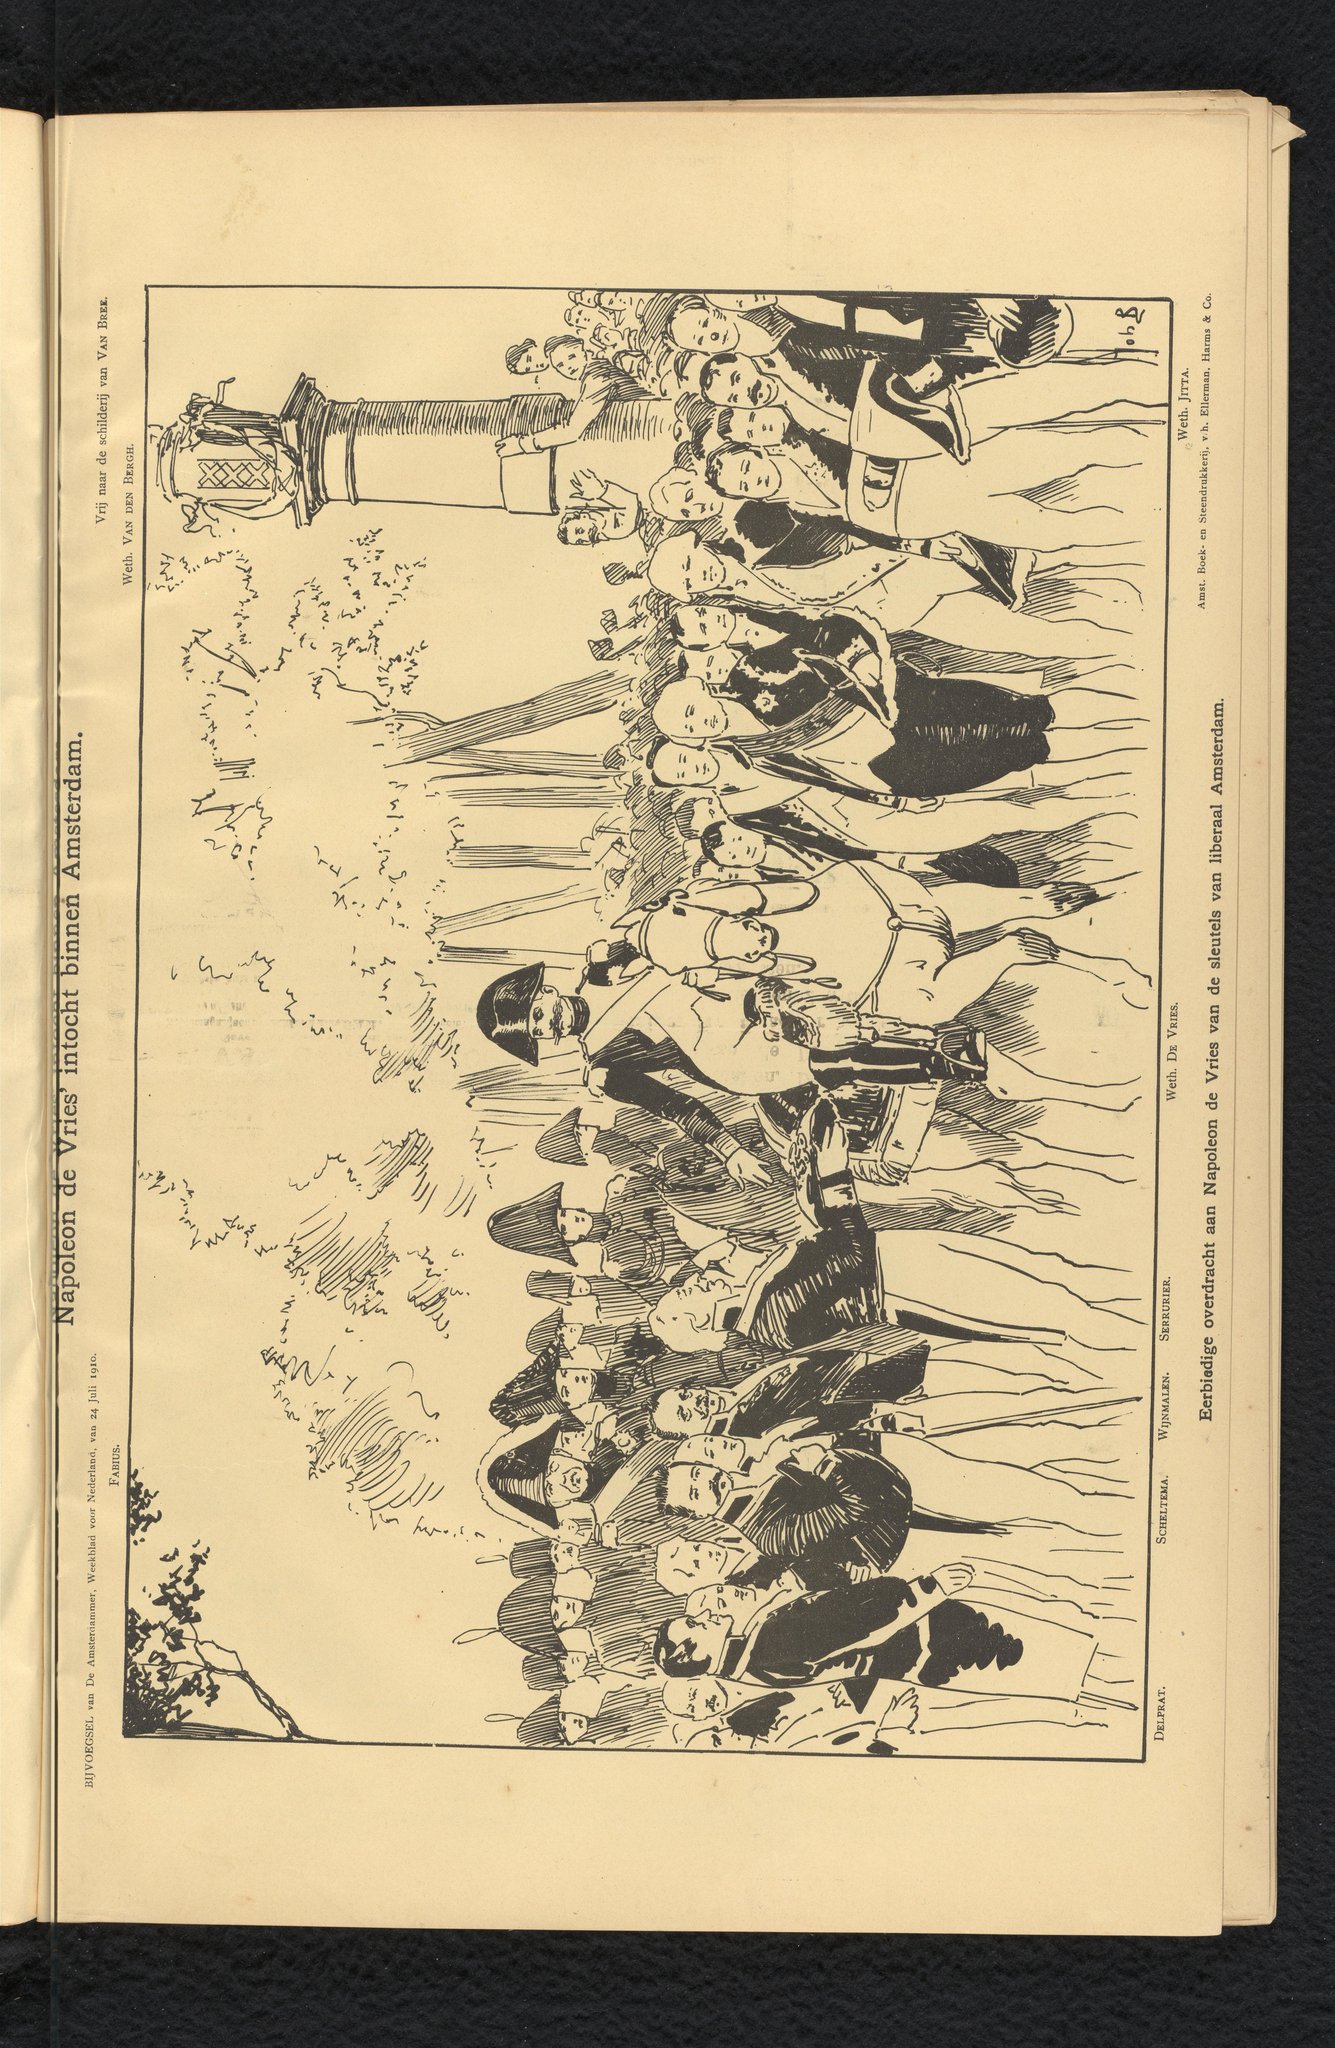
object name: cartoon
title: Napoleon de Vries' intocht binnen Amsterdam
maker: johan braakensiek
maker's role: draughtsman, print maker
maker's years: 1858-1940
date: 1910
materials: paper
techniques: lithograph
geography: netherlands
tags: napoleon i (emperor of the french), triumphal entry and public reception, pageant, 'entrée solennelle', 'joyeuse entrée', municipal government, political caricatures and satires, amsterdam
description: Wethouder Simon de Vries Czn. als Napoleon die te paard Amsterdam binnentrekt.